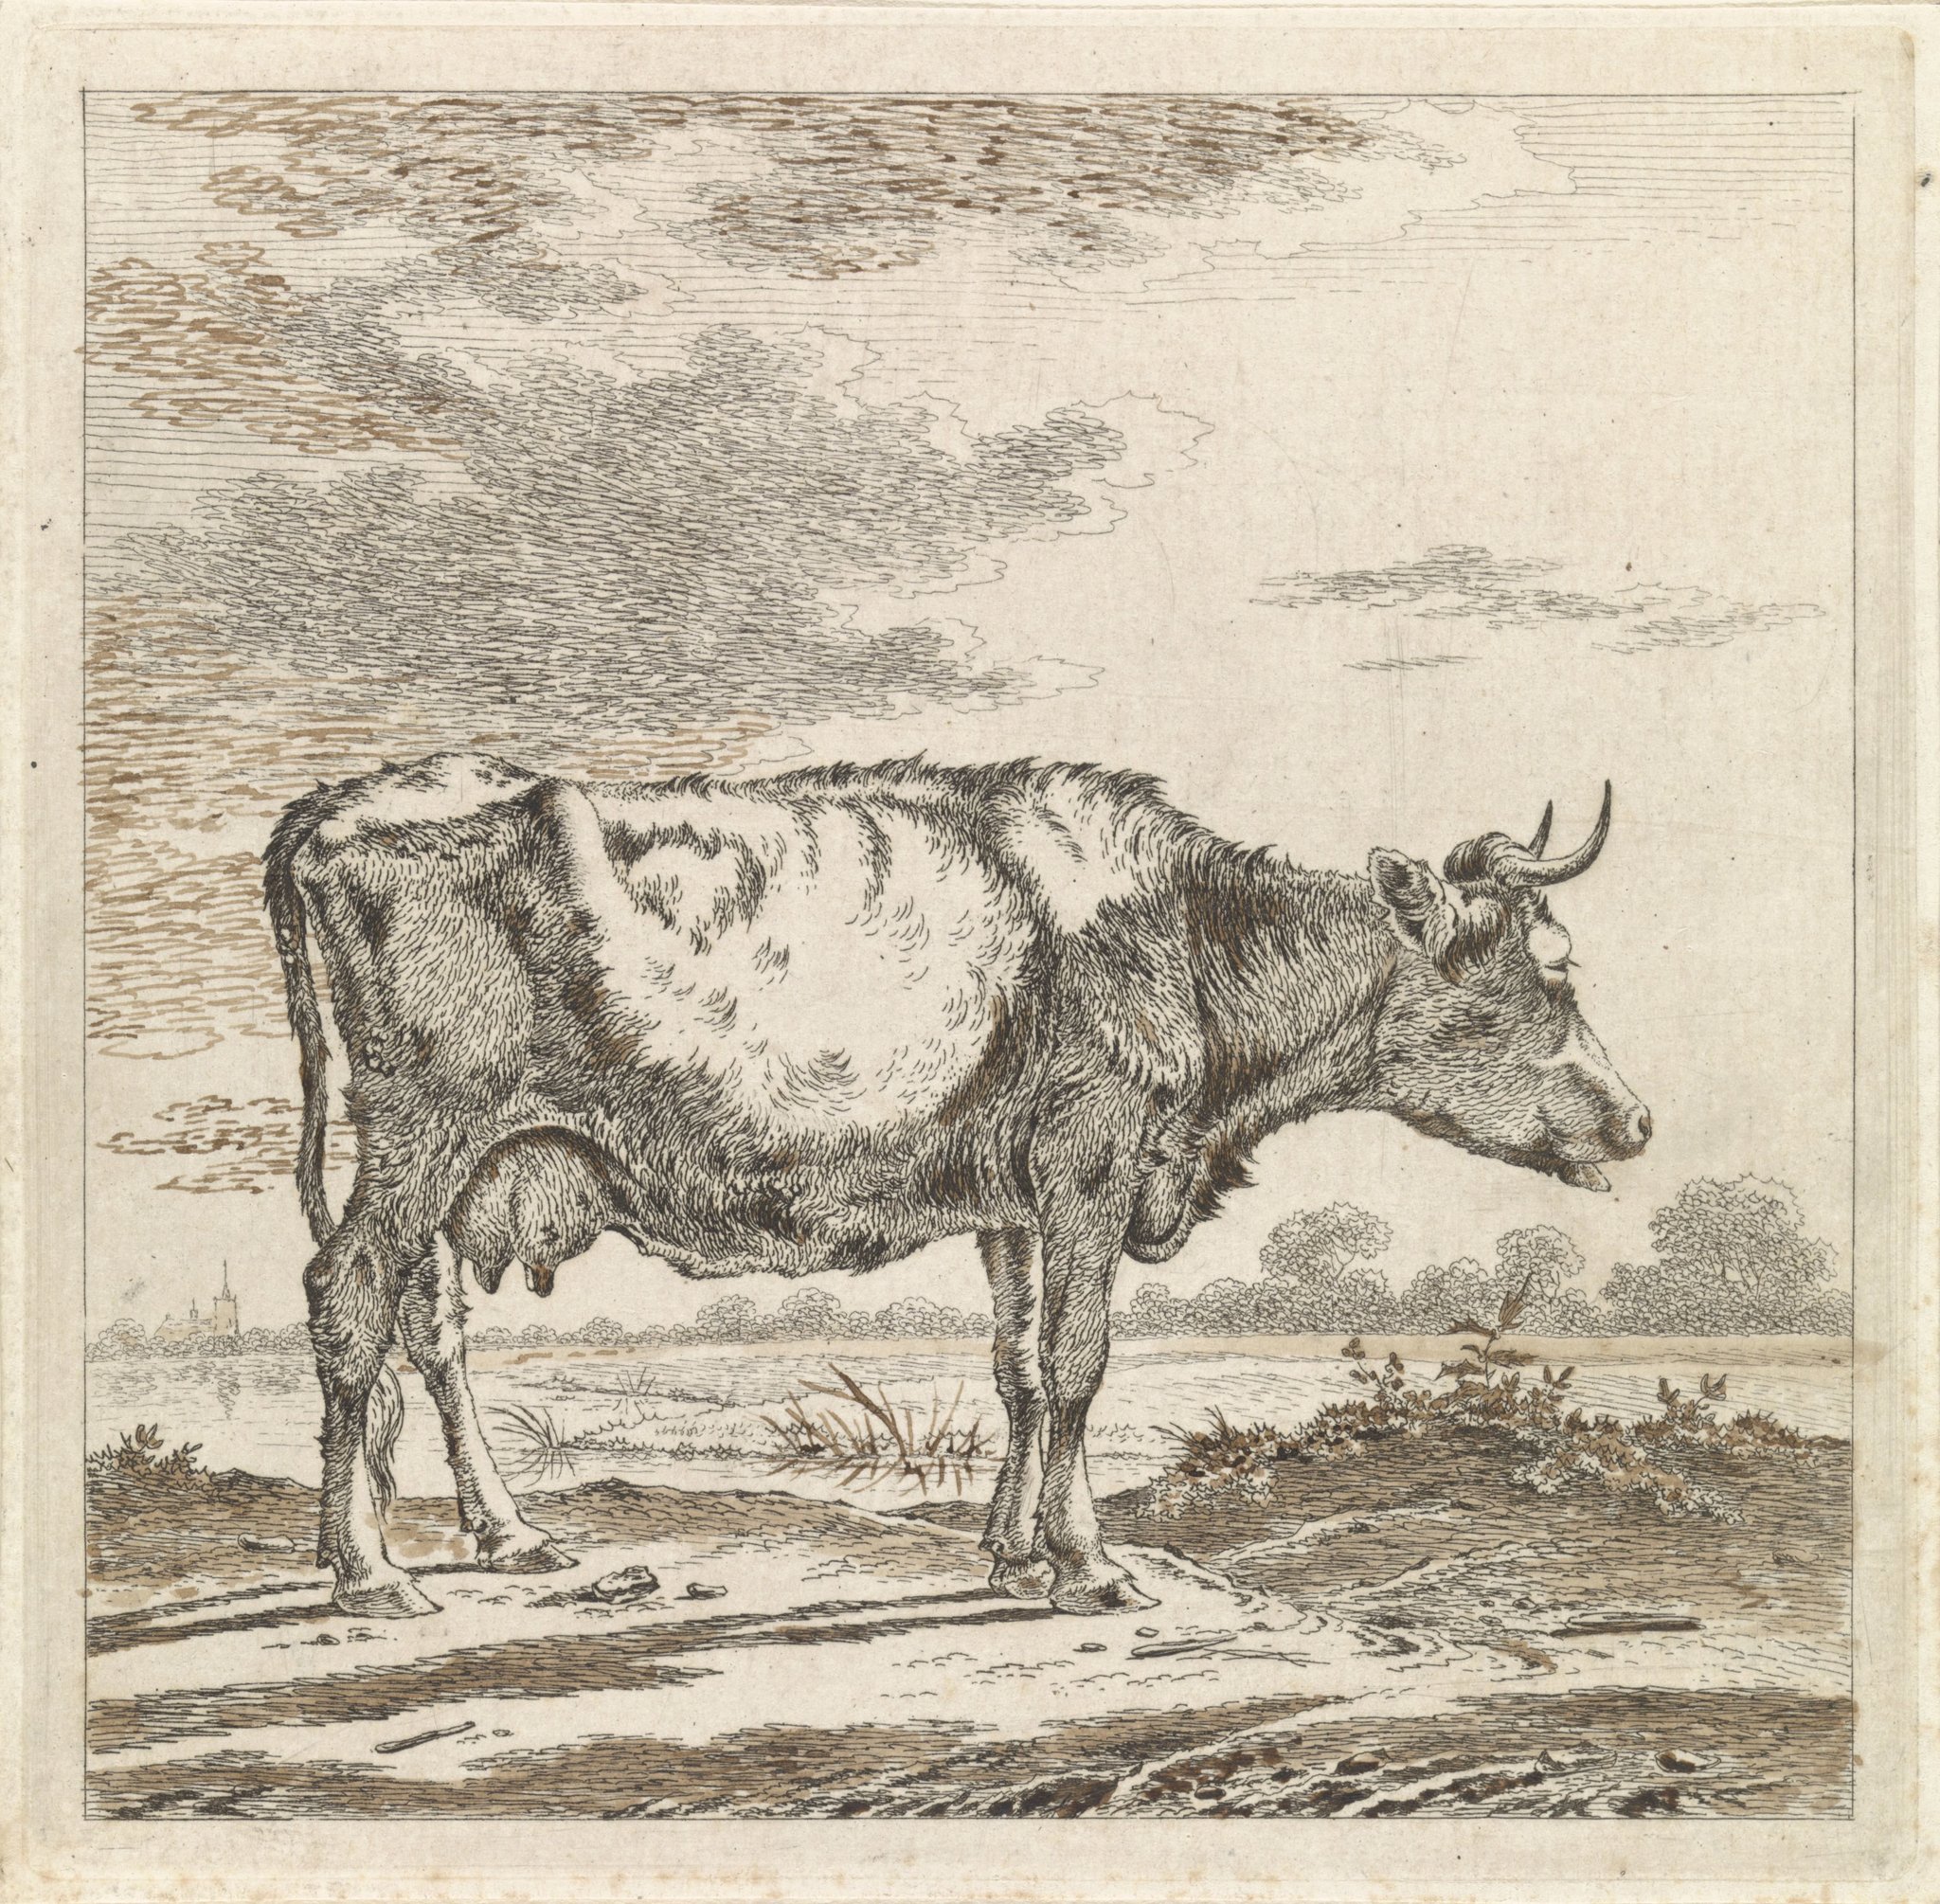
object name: print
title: Landschap met koe aan waterkant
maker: pieter janson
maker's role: draughtsman, print maker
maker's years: 1765-1851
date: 1780-1851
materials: paper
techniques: brush, etching, pen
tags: cow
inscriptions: collector's mark: Lugt 2228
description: Landschap met koe aan waterkant, naar rechts. Proefdruk met aanpassingen van de kunstenaar in pen en penseel in bruin.